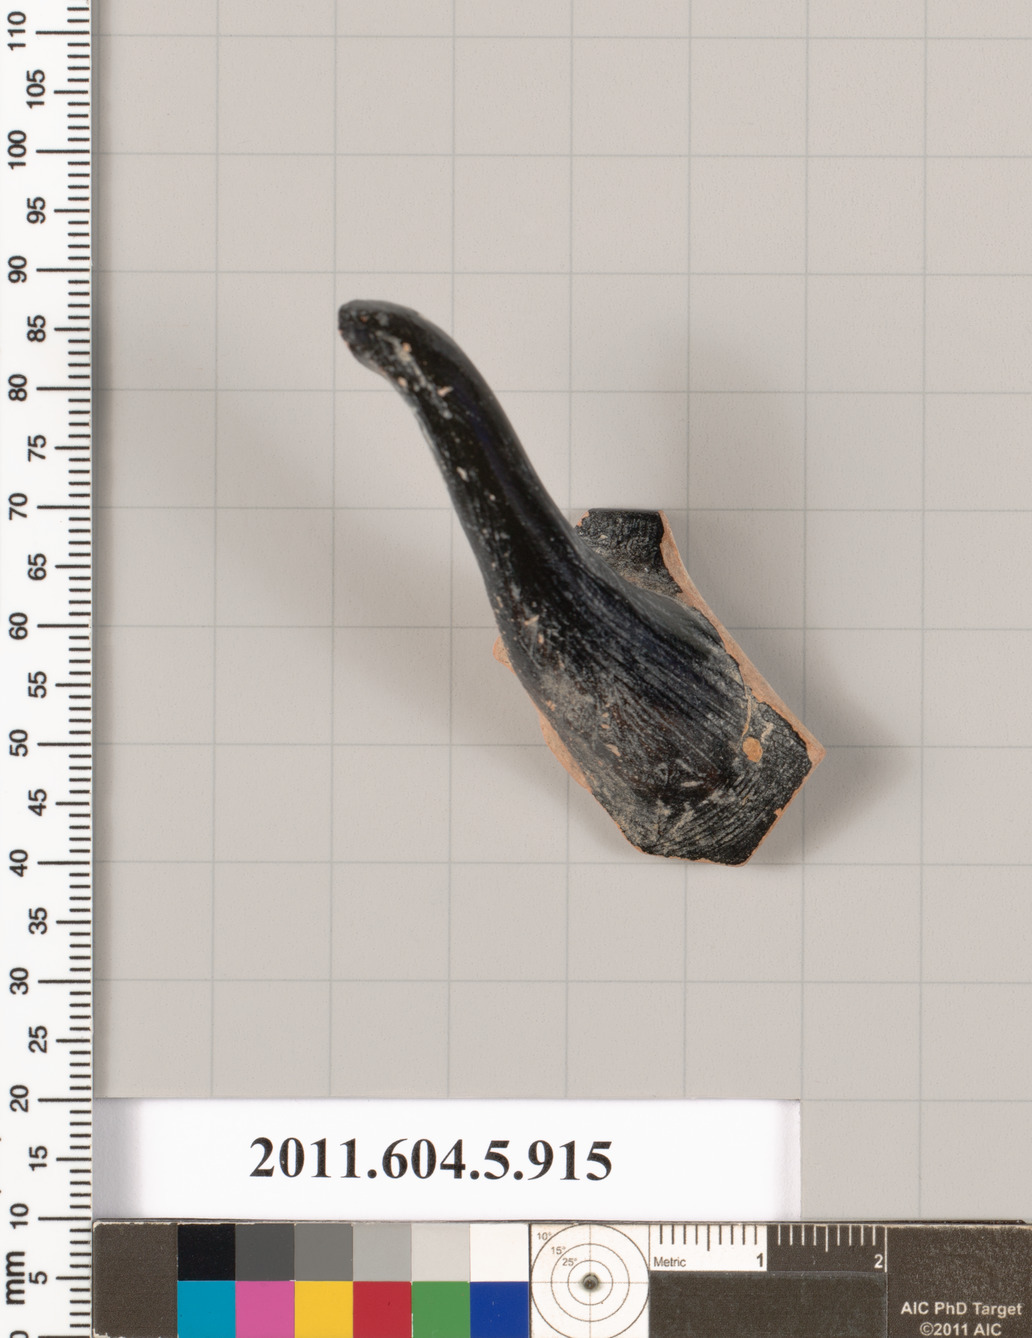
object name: kylix fragment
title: Terracotta rim fragment of a kylix (drinking cup)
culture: greek, attic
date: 600-401 BCE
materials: terracotta